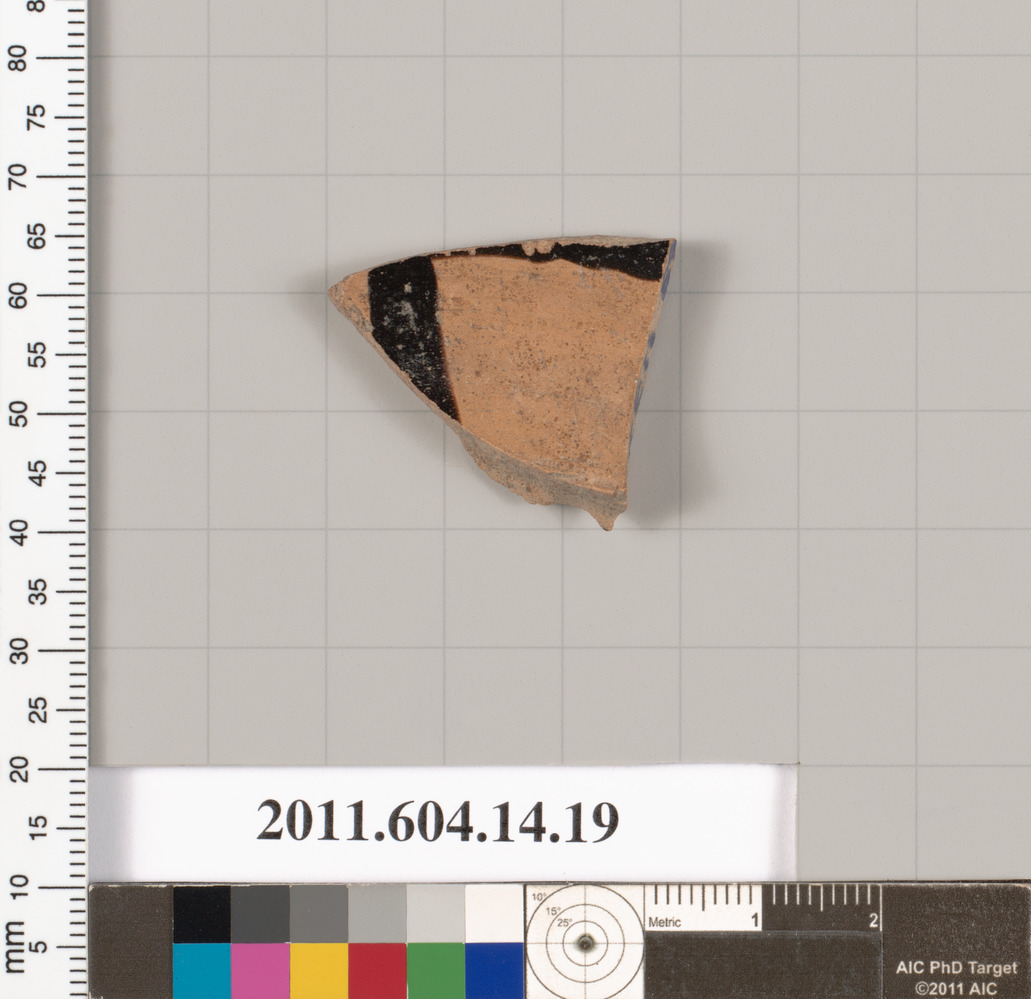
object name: kylix fragment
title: Terracotta fragment of kylix?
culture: unknown fabric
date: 600-401 BCE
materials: terracotta